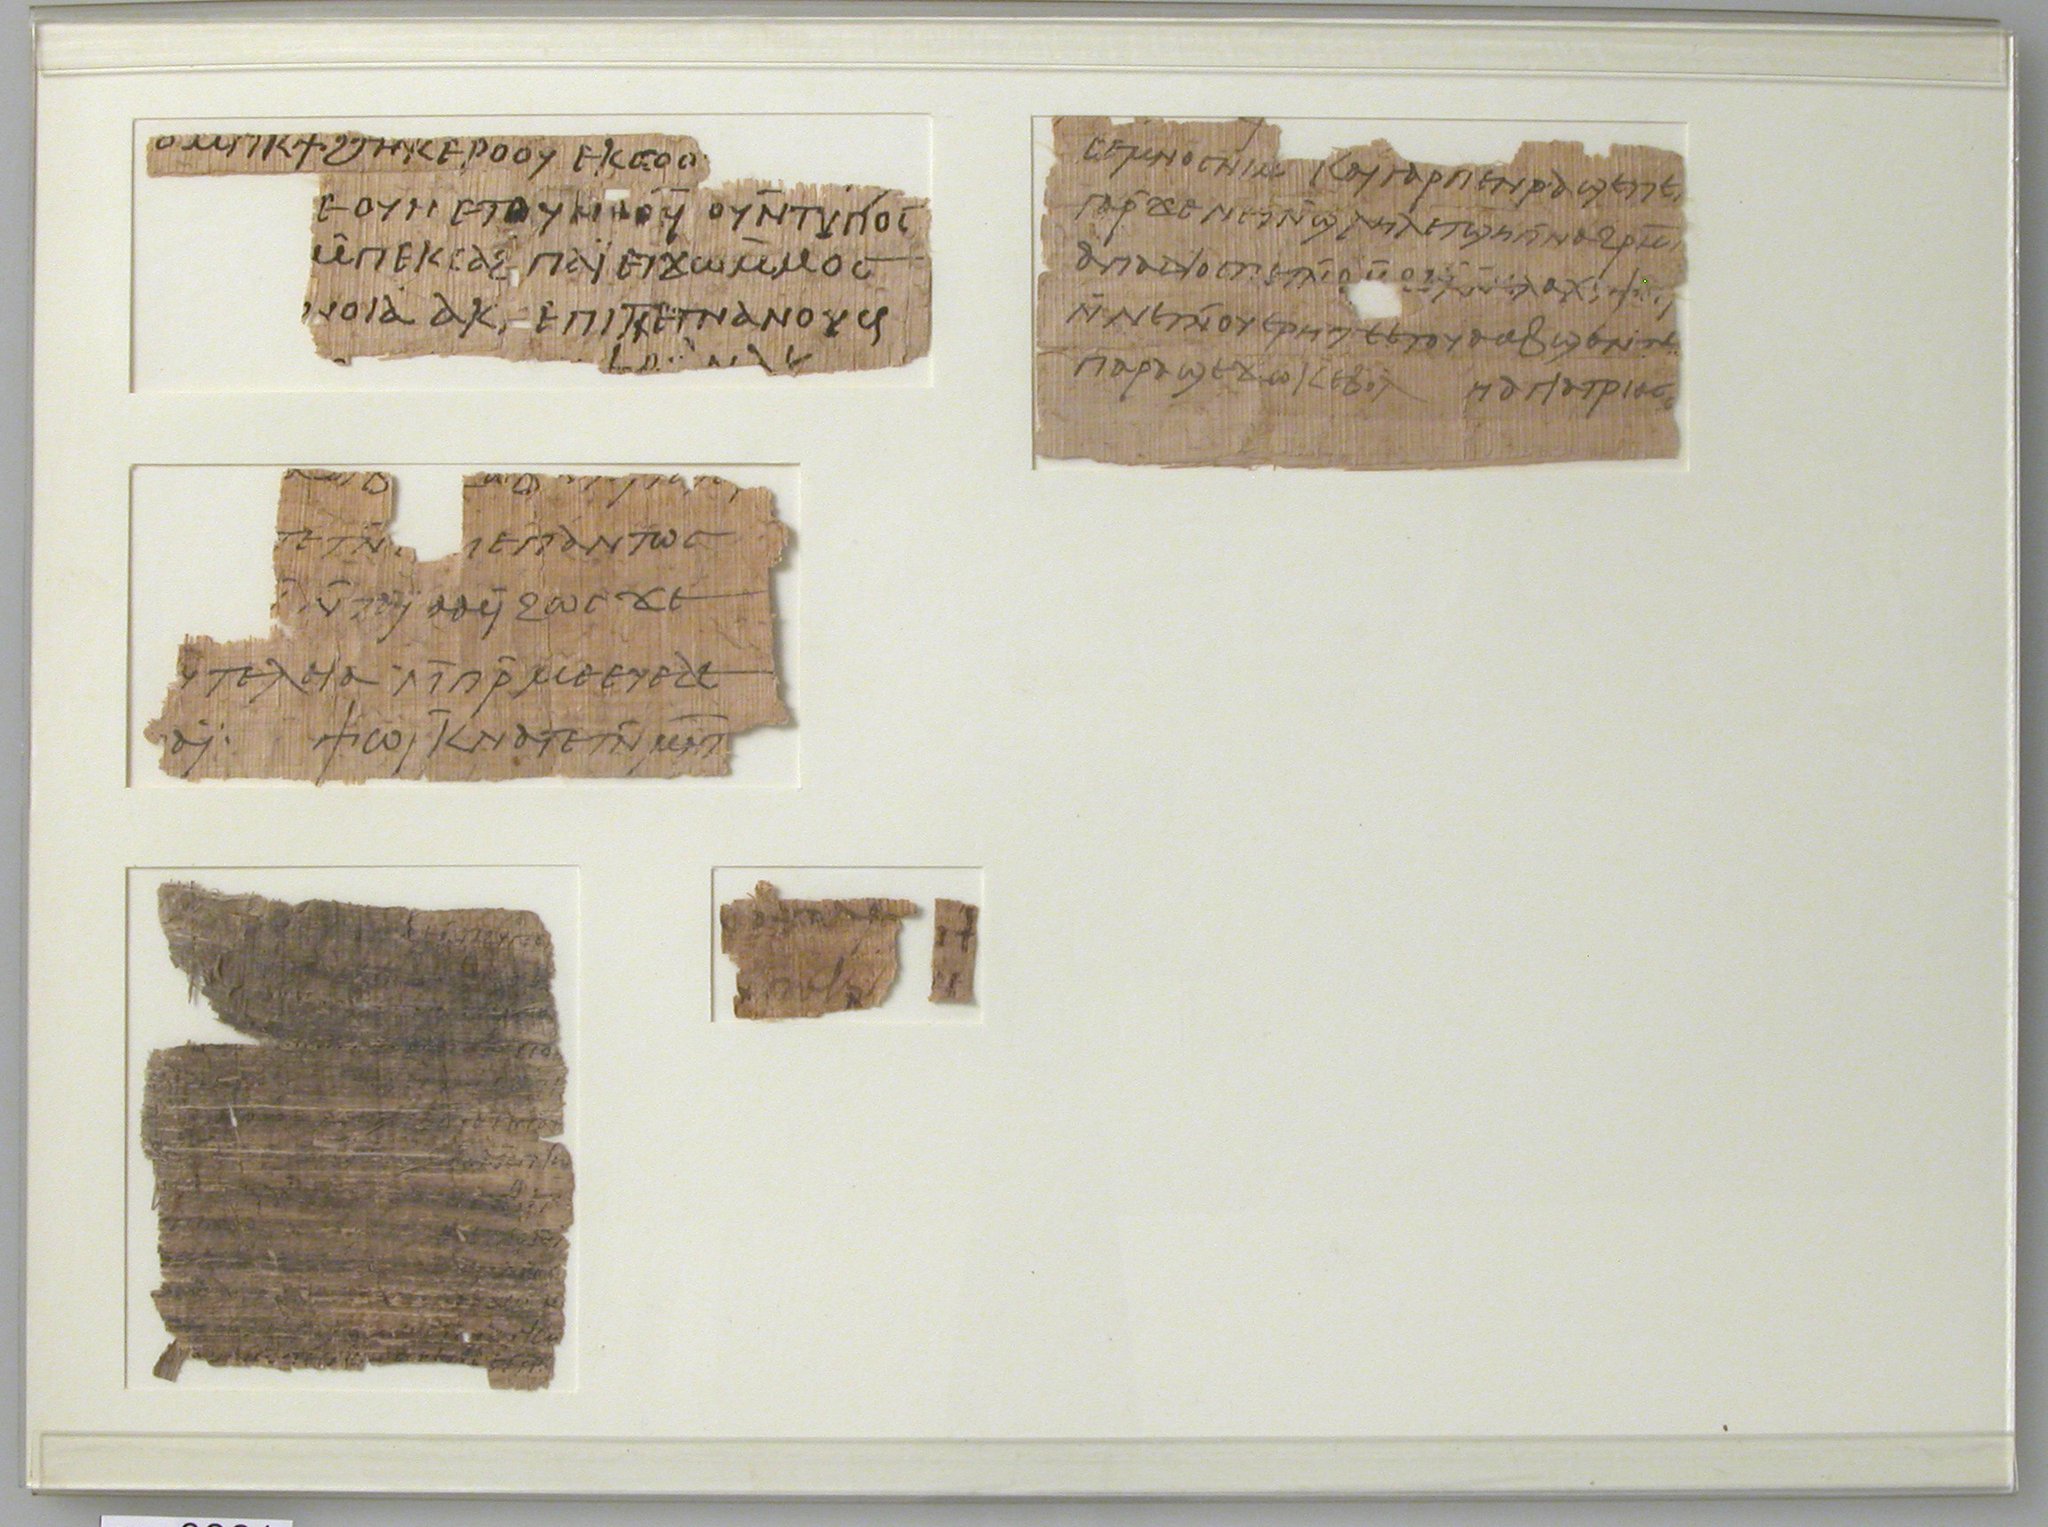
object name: fragment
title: Papyri Fragments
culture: coptic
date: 601-700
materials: ink, papyrus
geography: egypt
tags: documents